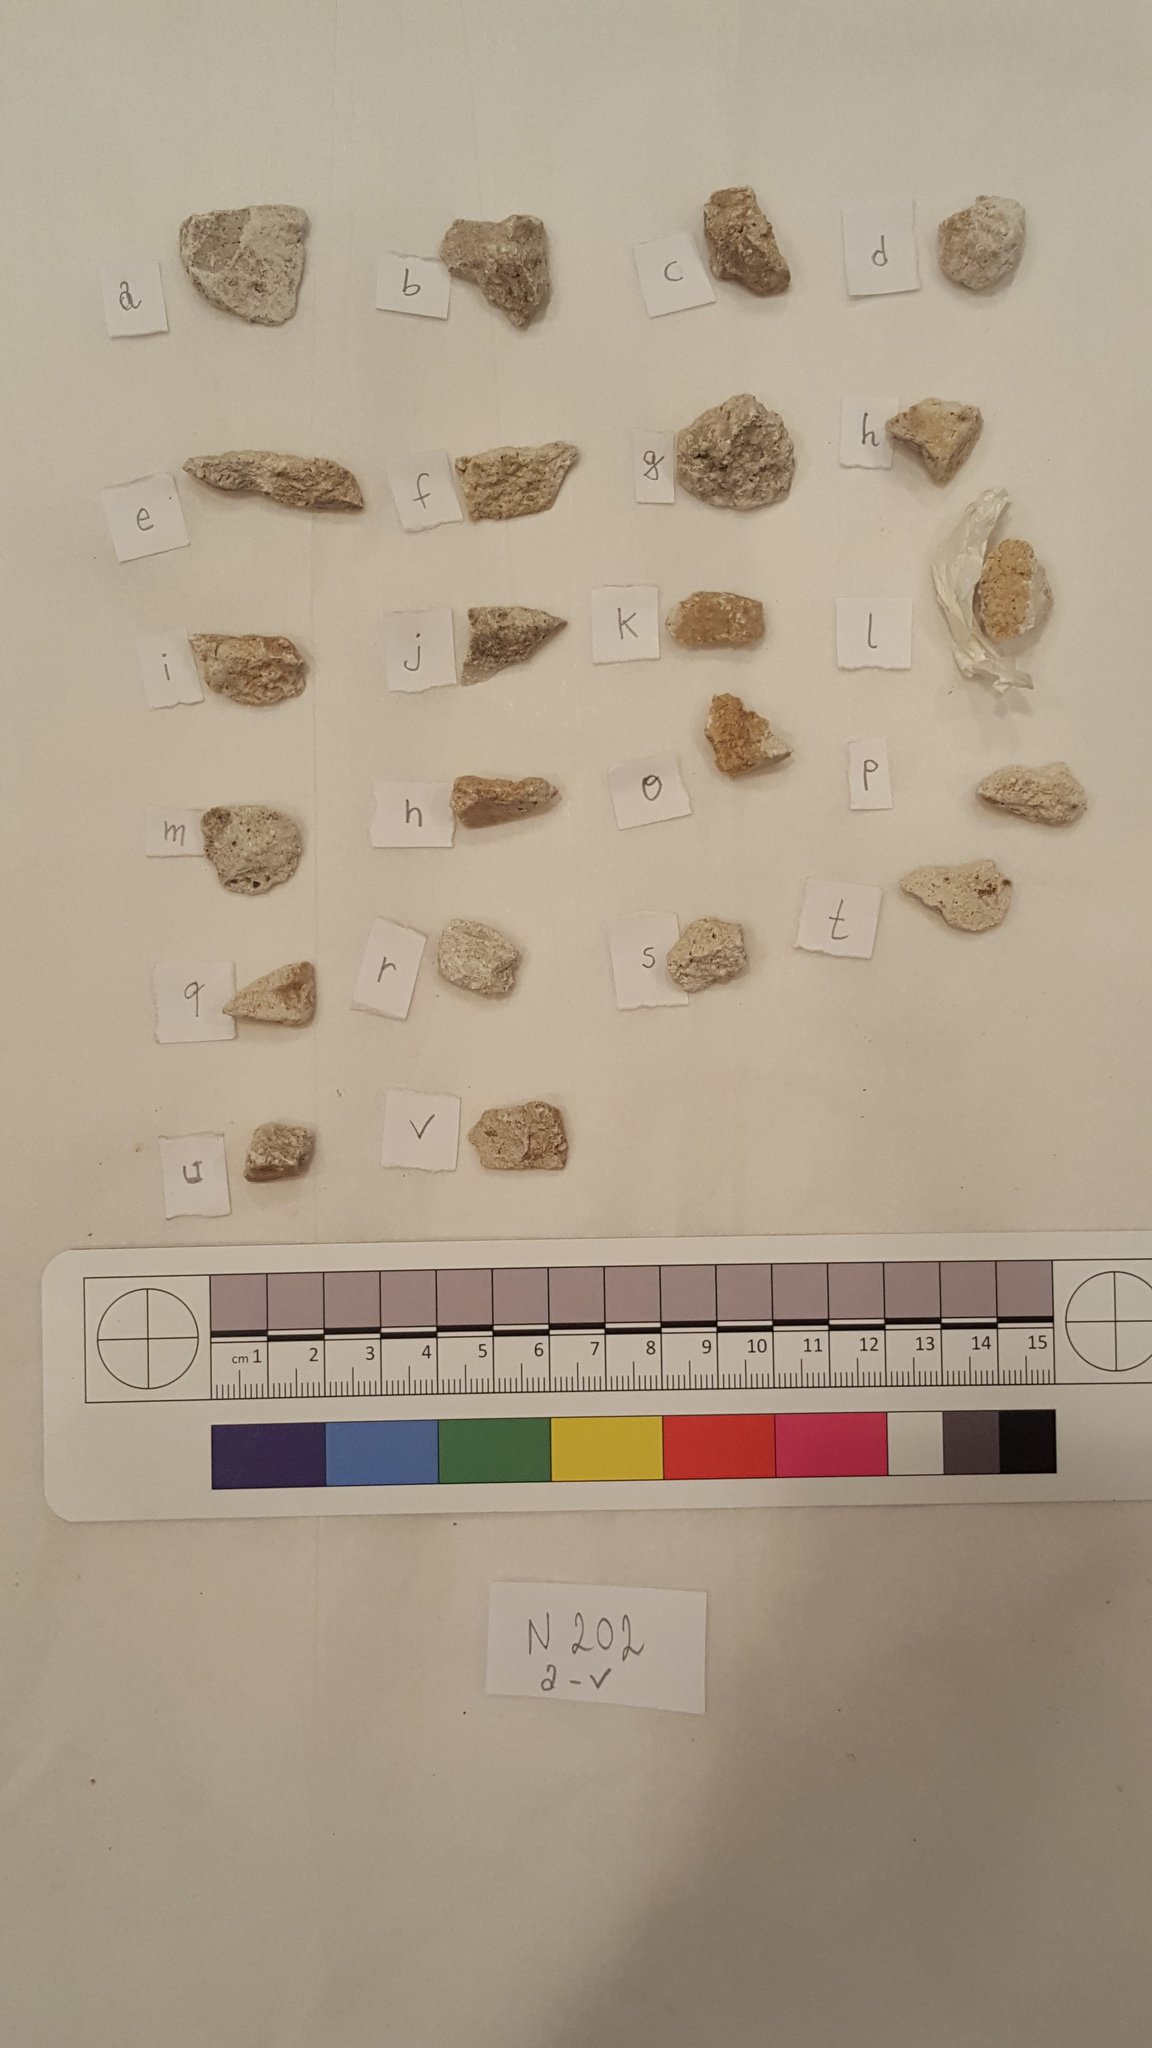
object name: fragment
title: Stucco Fragment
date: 701-1200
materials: plaster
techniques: painting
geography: iran